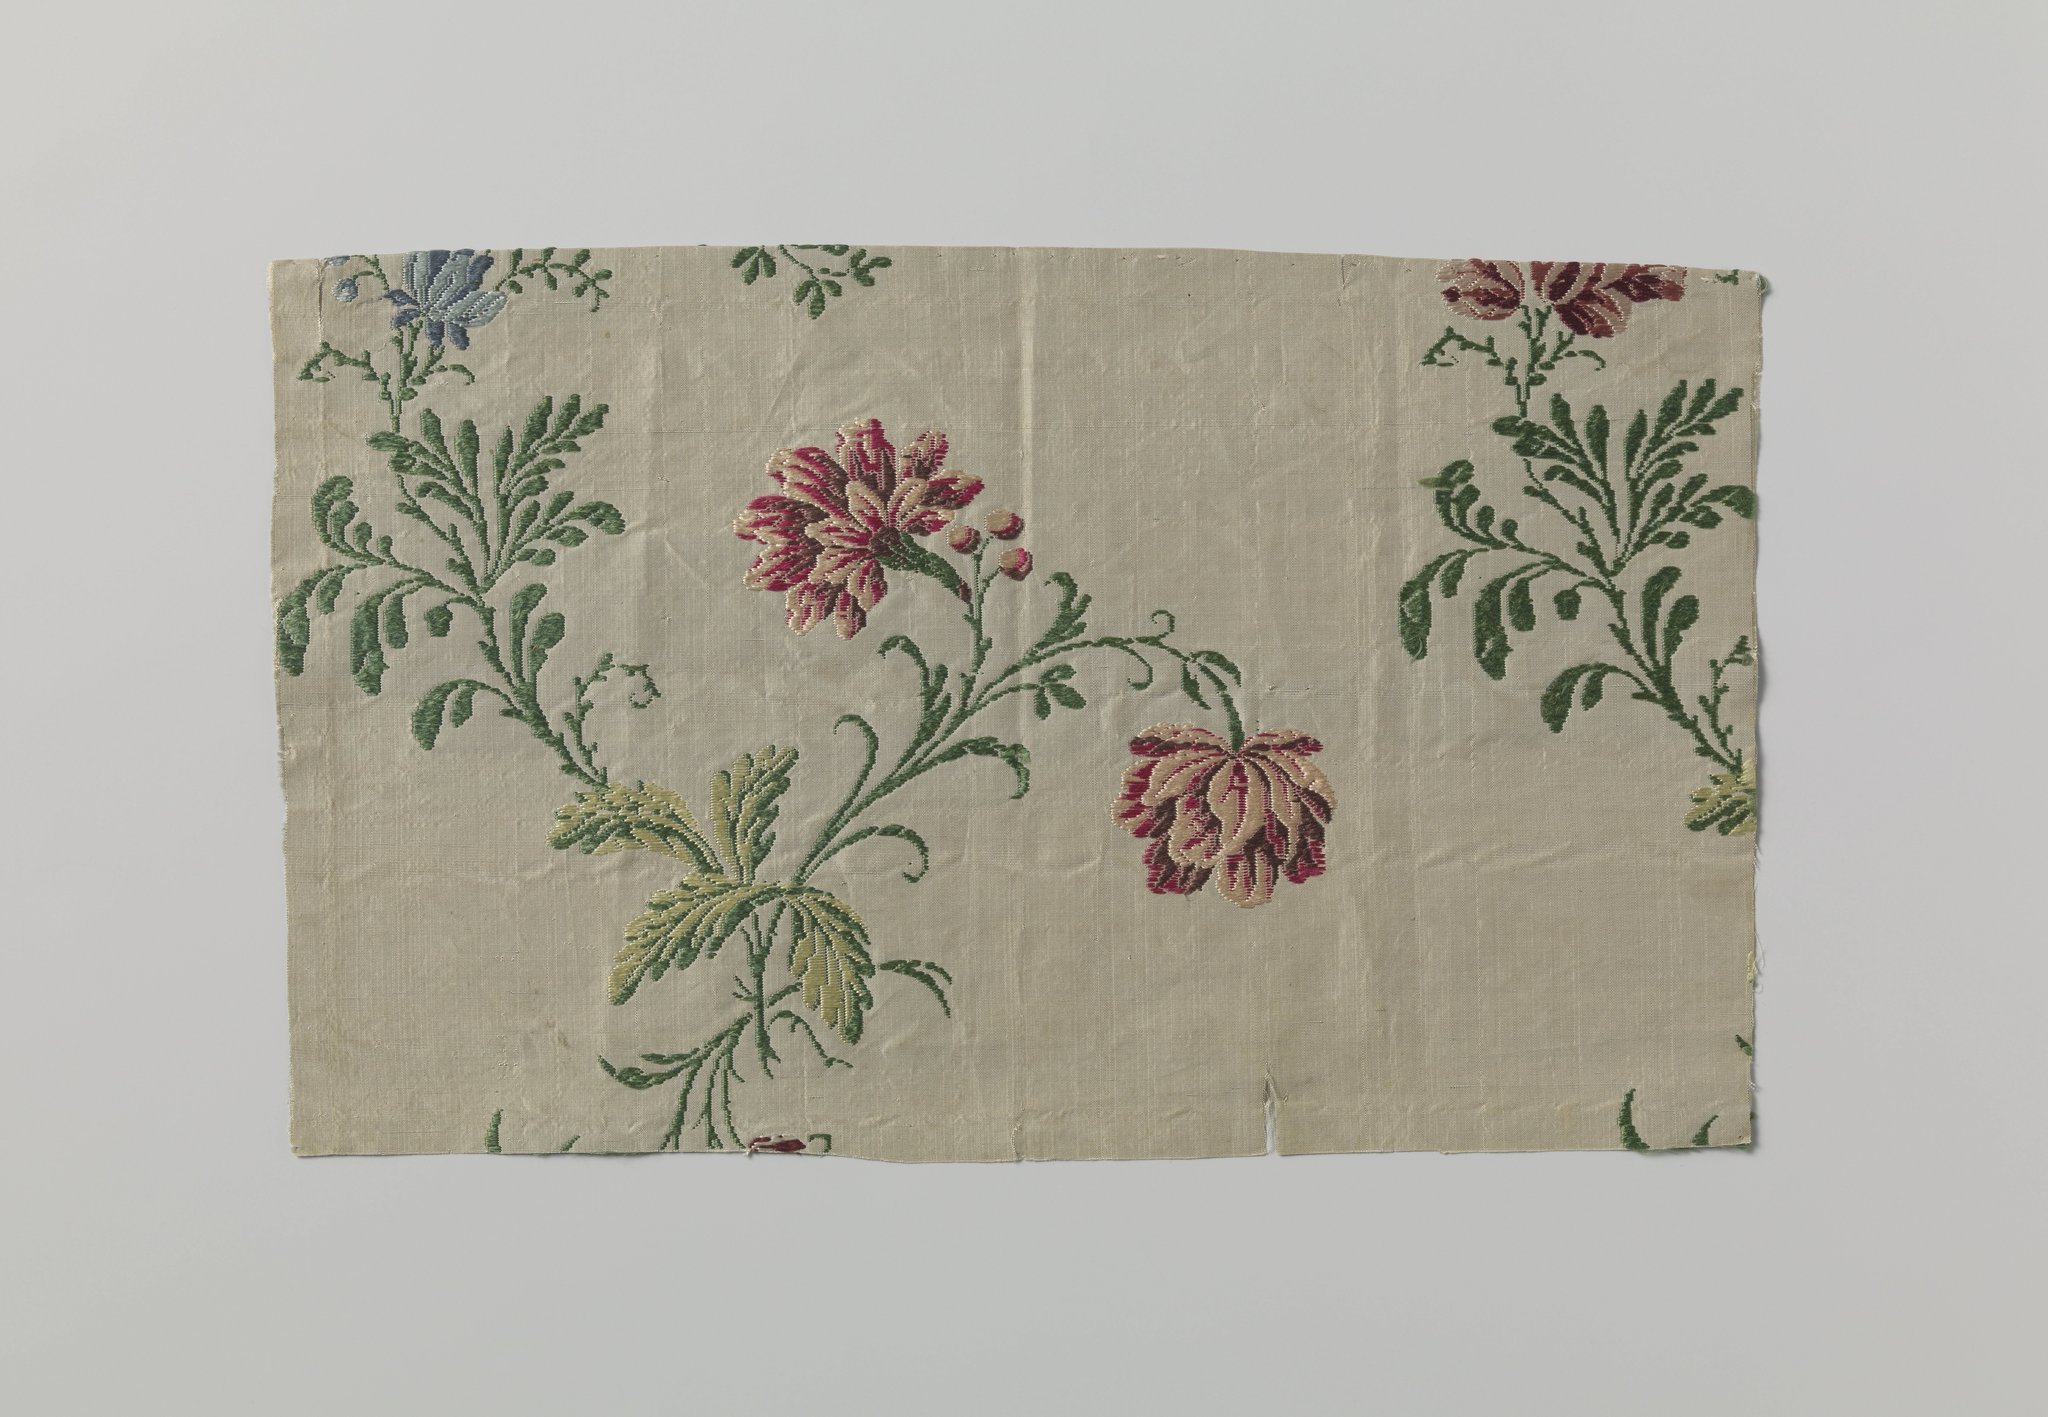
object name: fragment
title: Fragment witte gebrocheerde zijde met veelkleurige bloemtakken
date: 1730-1760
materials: silk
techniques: brocade, weave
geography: netherlands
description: Een fragment van witte zijde, met verschillend gekleurde bloemtakken.